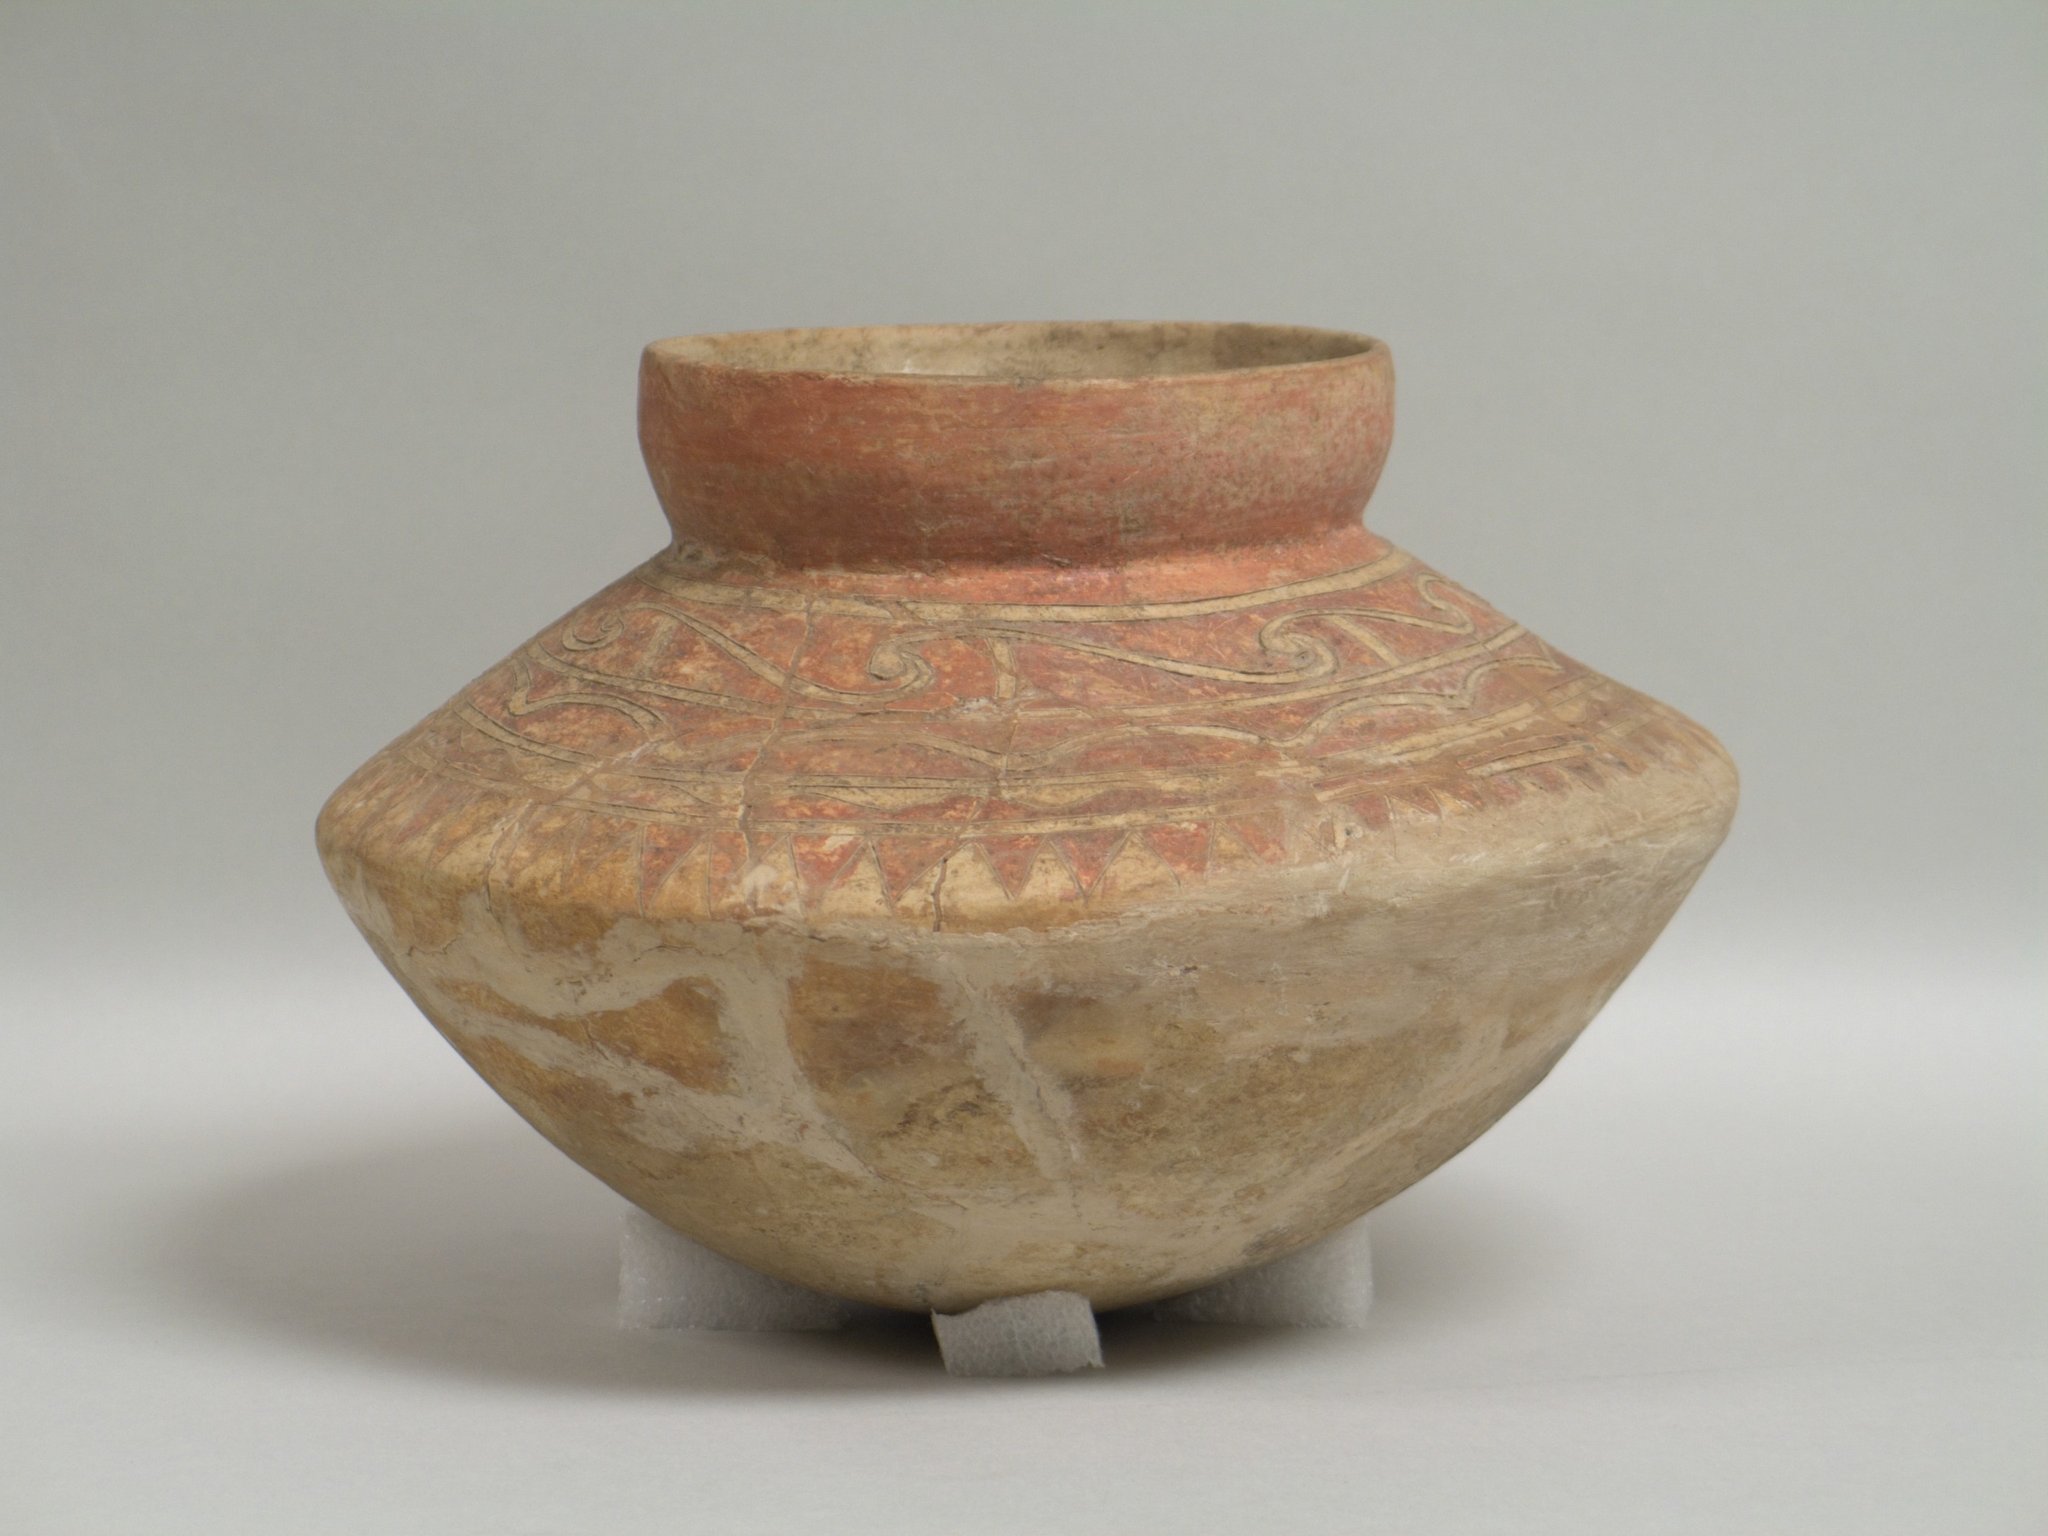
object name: vessel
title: Vessel with Bulbous Body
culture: thai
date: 1000-300 BCE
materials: earthenware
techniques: incising